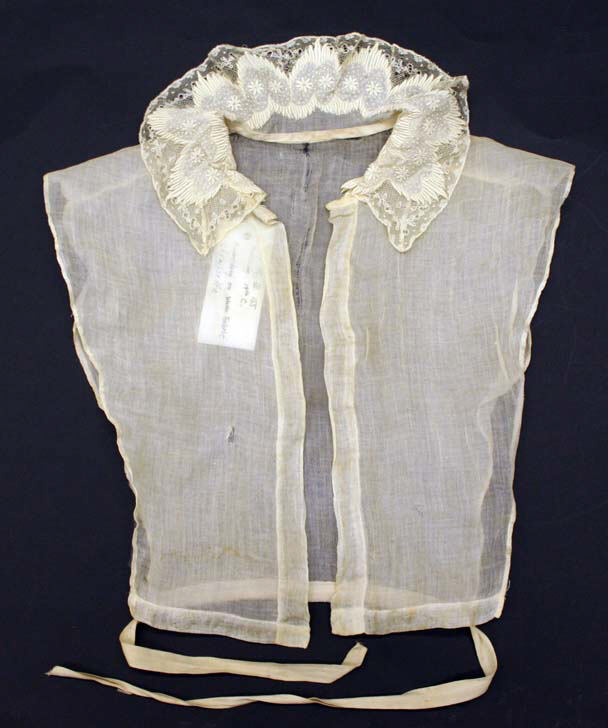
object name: dickey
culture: american or european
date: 1700-1945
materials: cotton